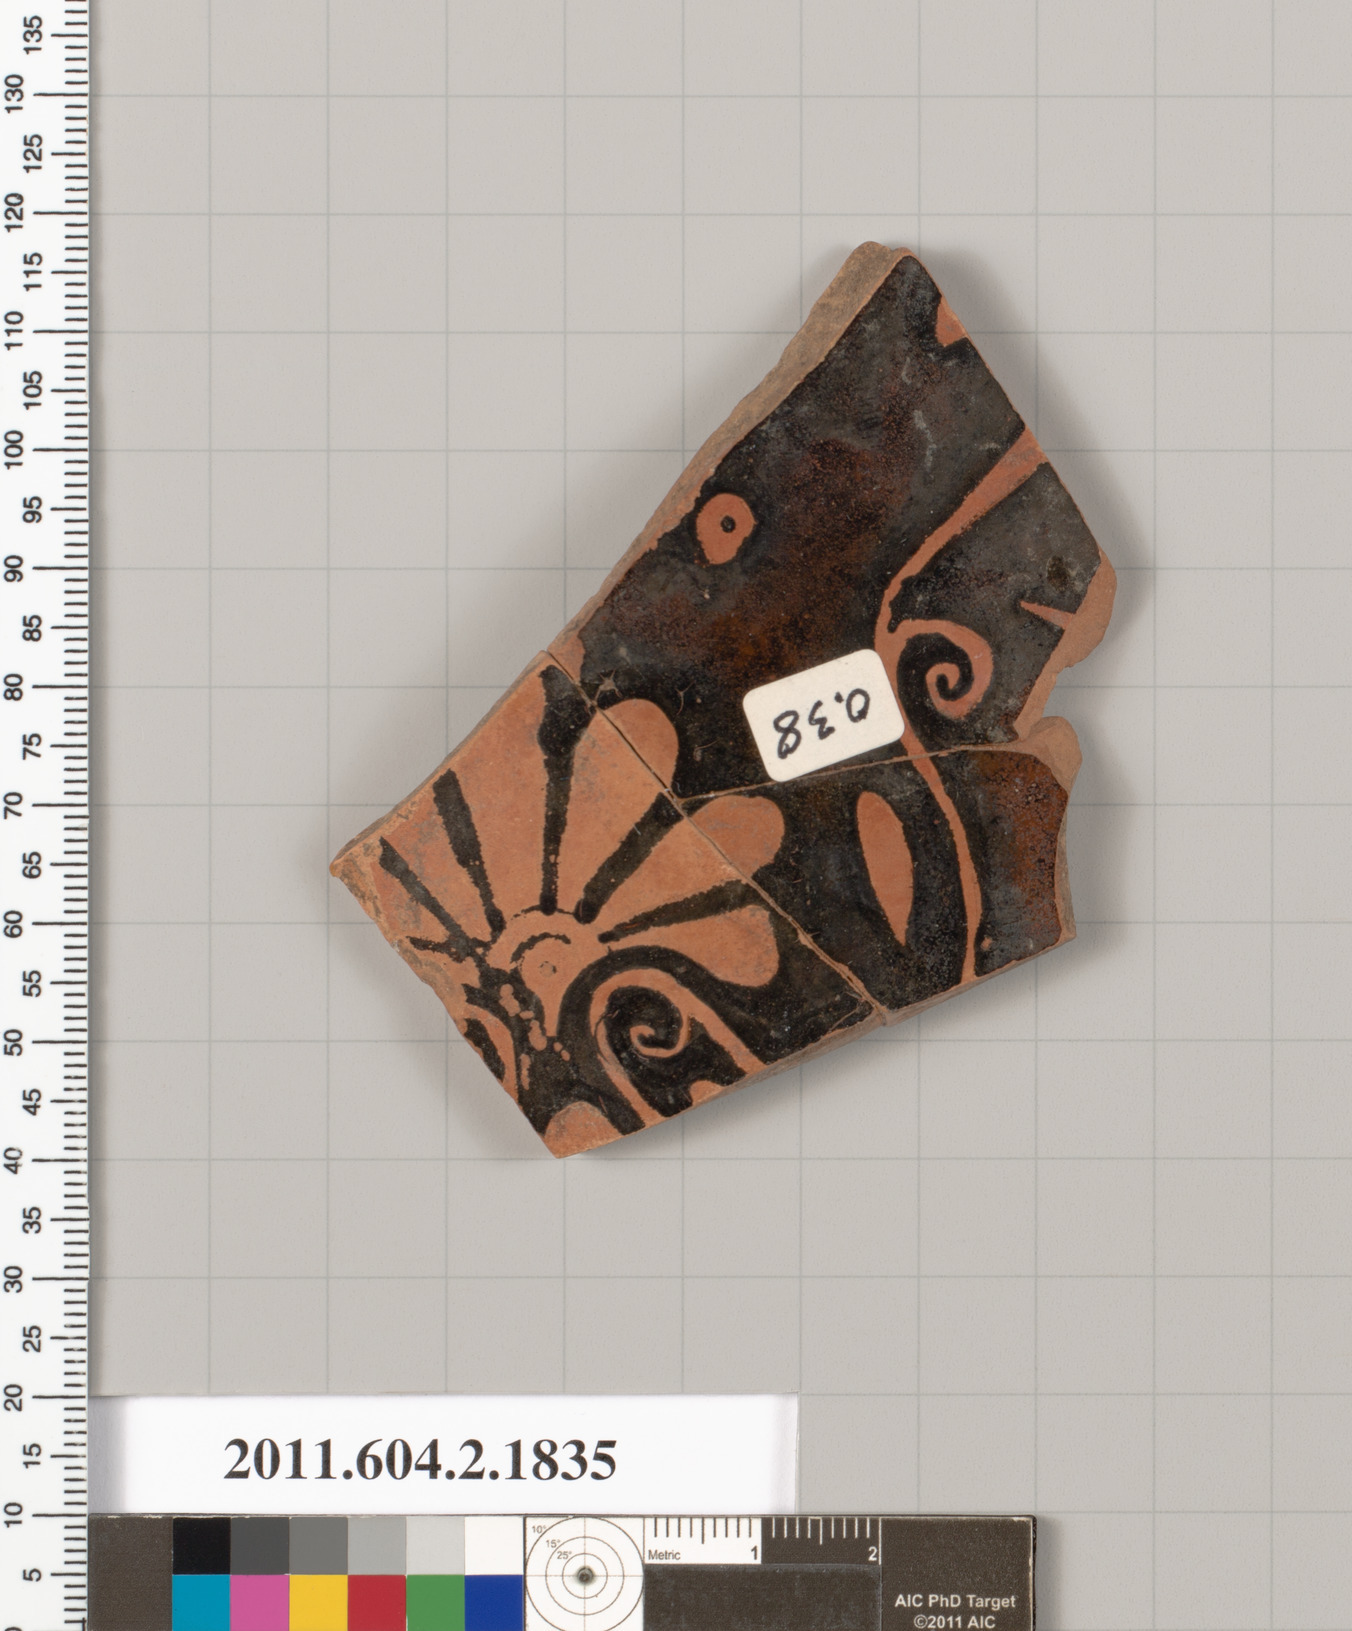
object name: skyphos fragment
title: Terracotta fragment of a skyphos (deep drinking cup)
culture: greek, attic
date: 450-426 BCE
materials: terracotta